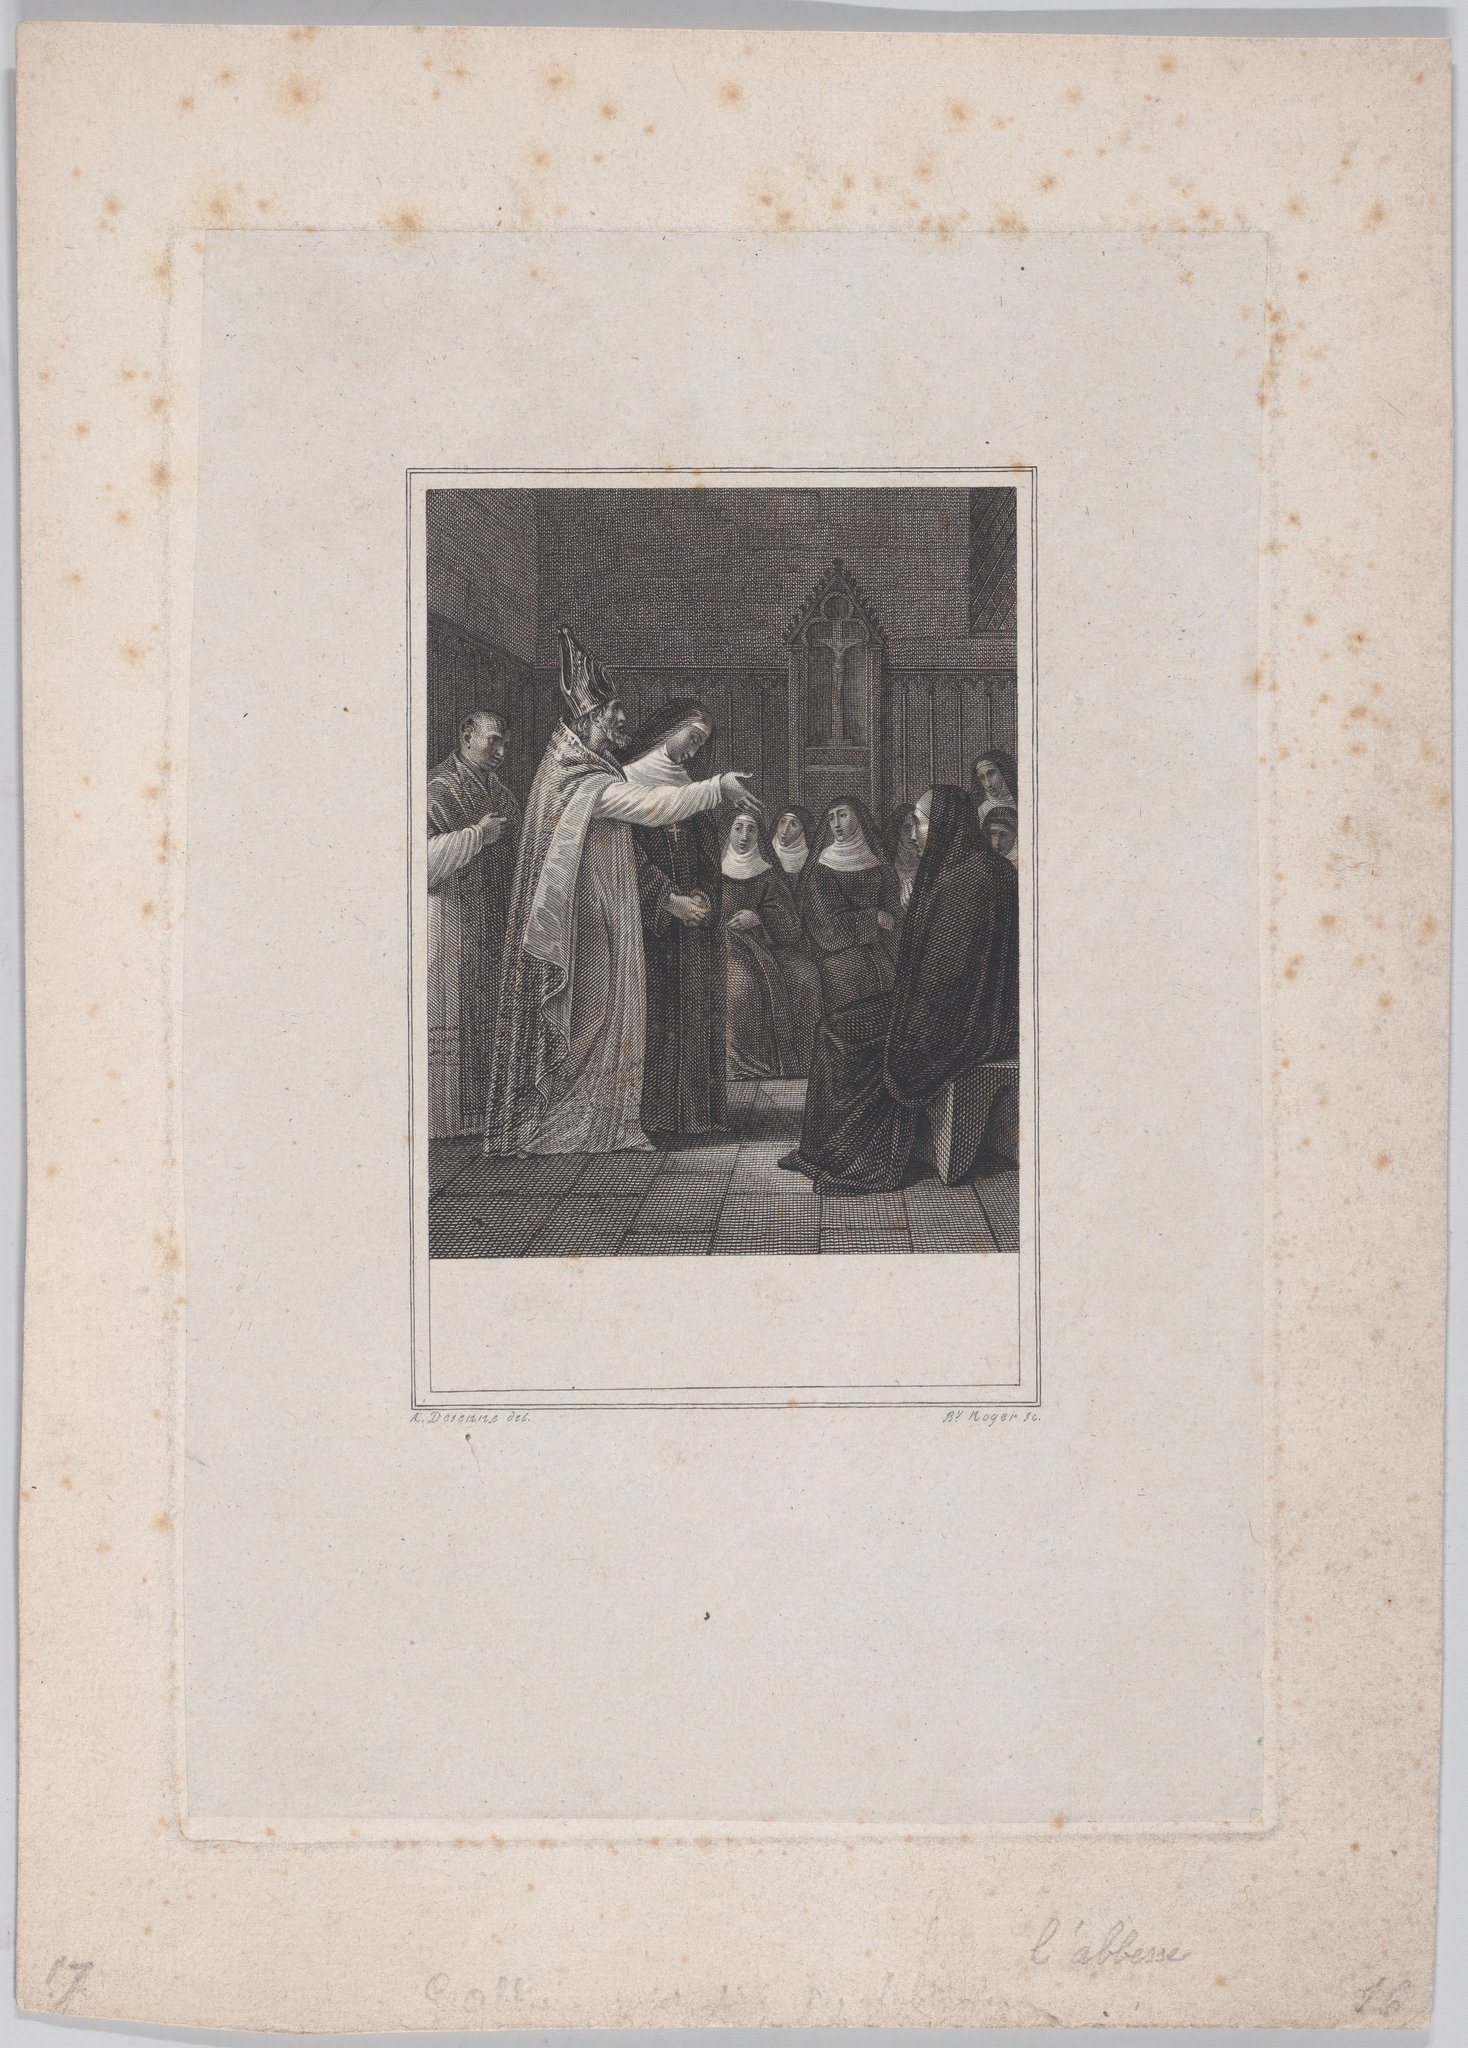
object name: print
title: A priest and a group of nuns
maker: barthélemy joseph fulcran roger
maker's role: artist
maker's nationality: french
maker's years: 1767-1841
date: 1823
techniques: engraving, etching